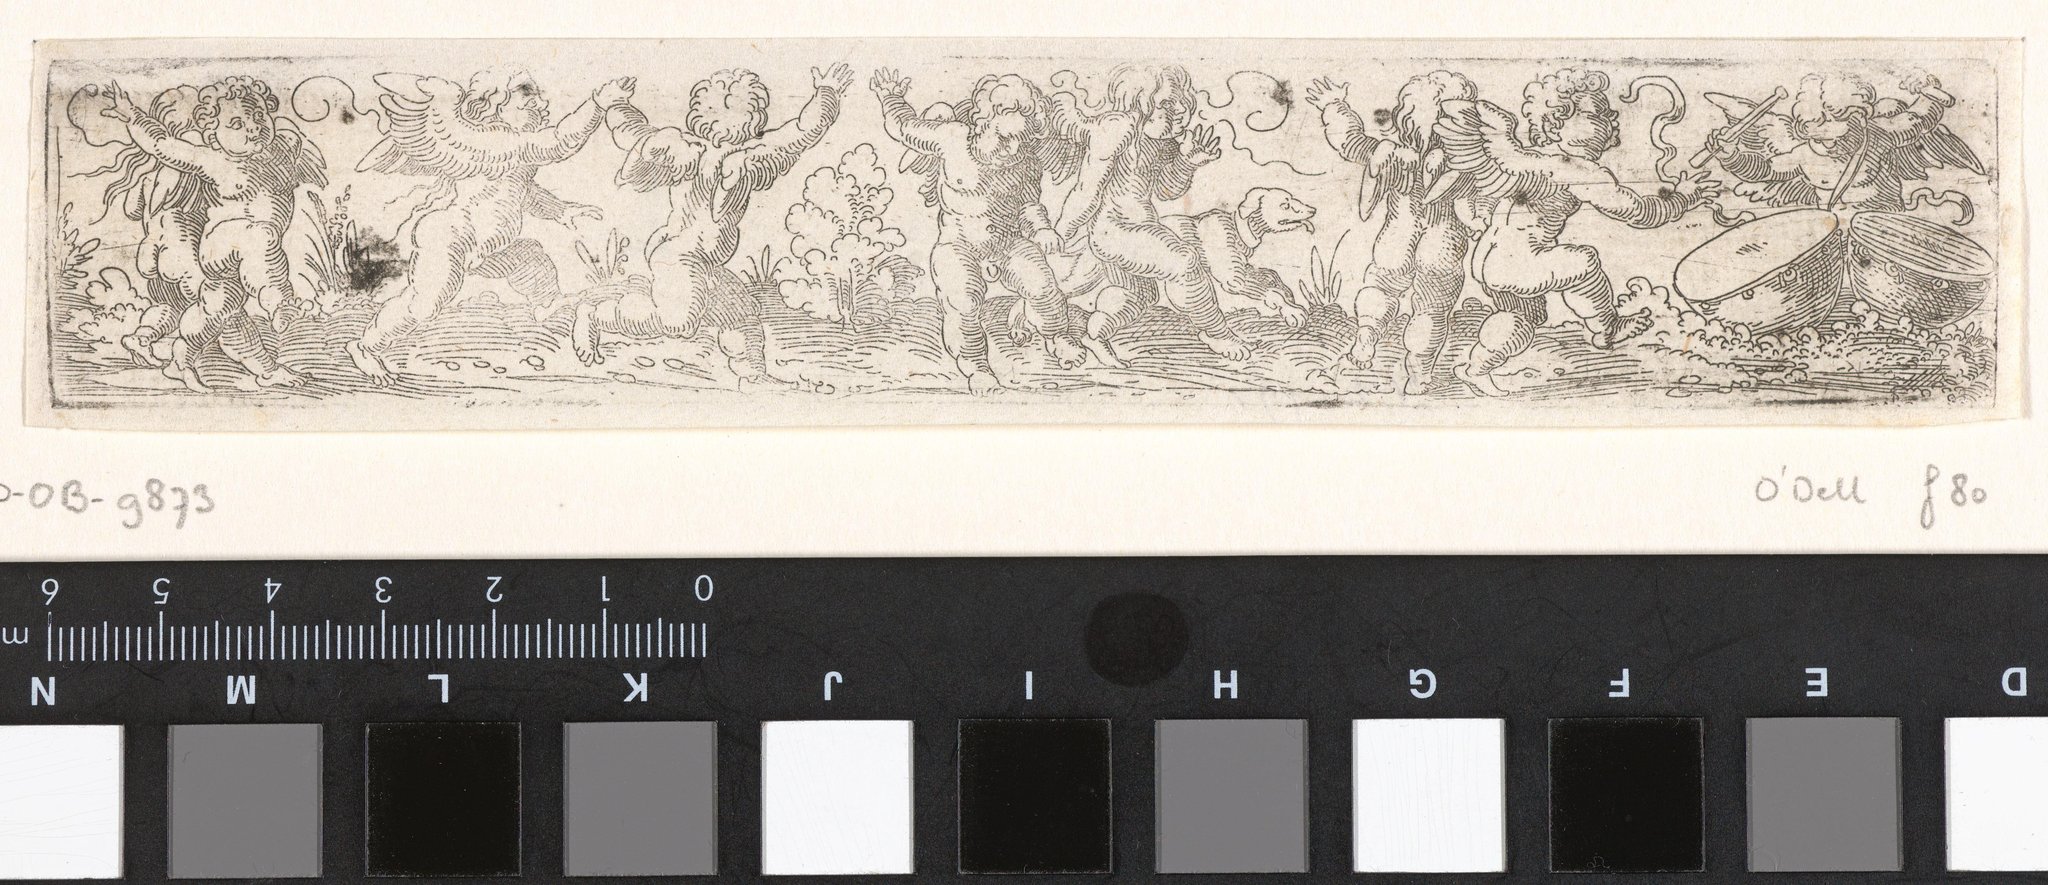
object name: print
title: Dansende en musicerende putti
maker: virgilius solis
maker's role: draughtsman, print maker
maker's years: 1514-1562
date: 1524-1562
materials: paper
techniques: etching